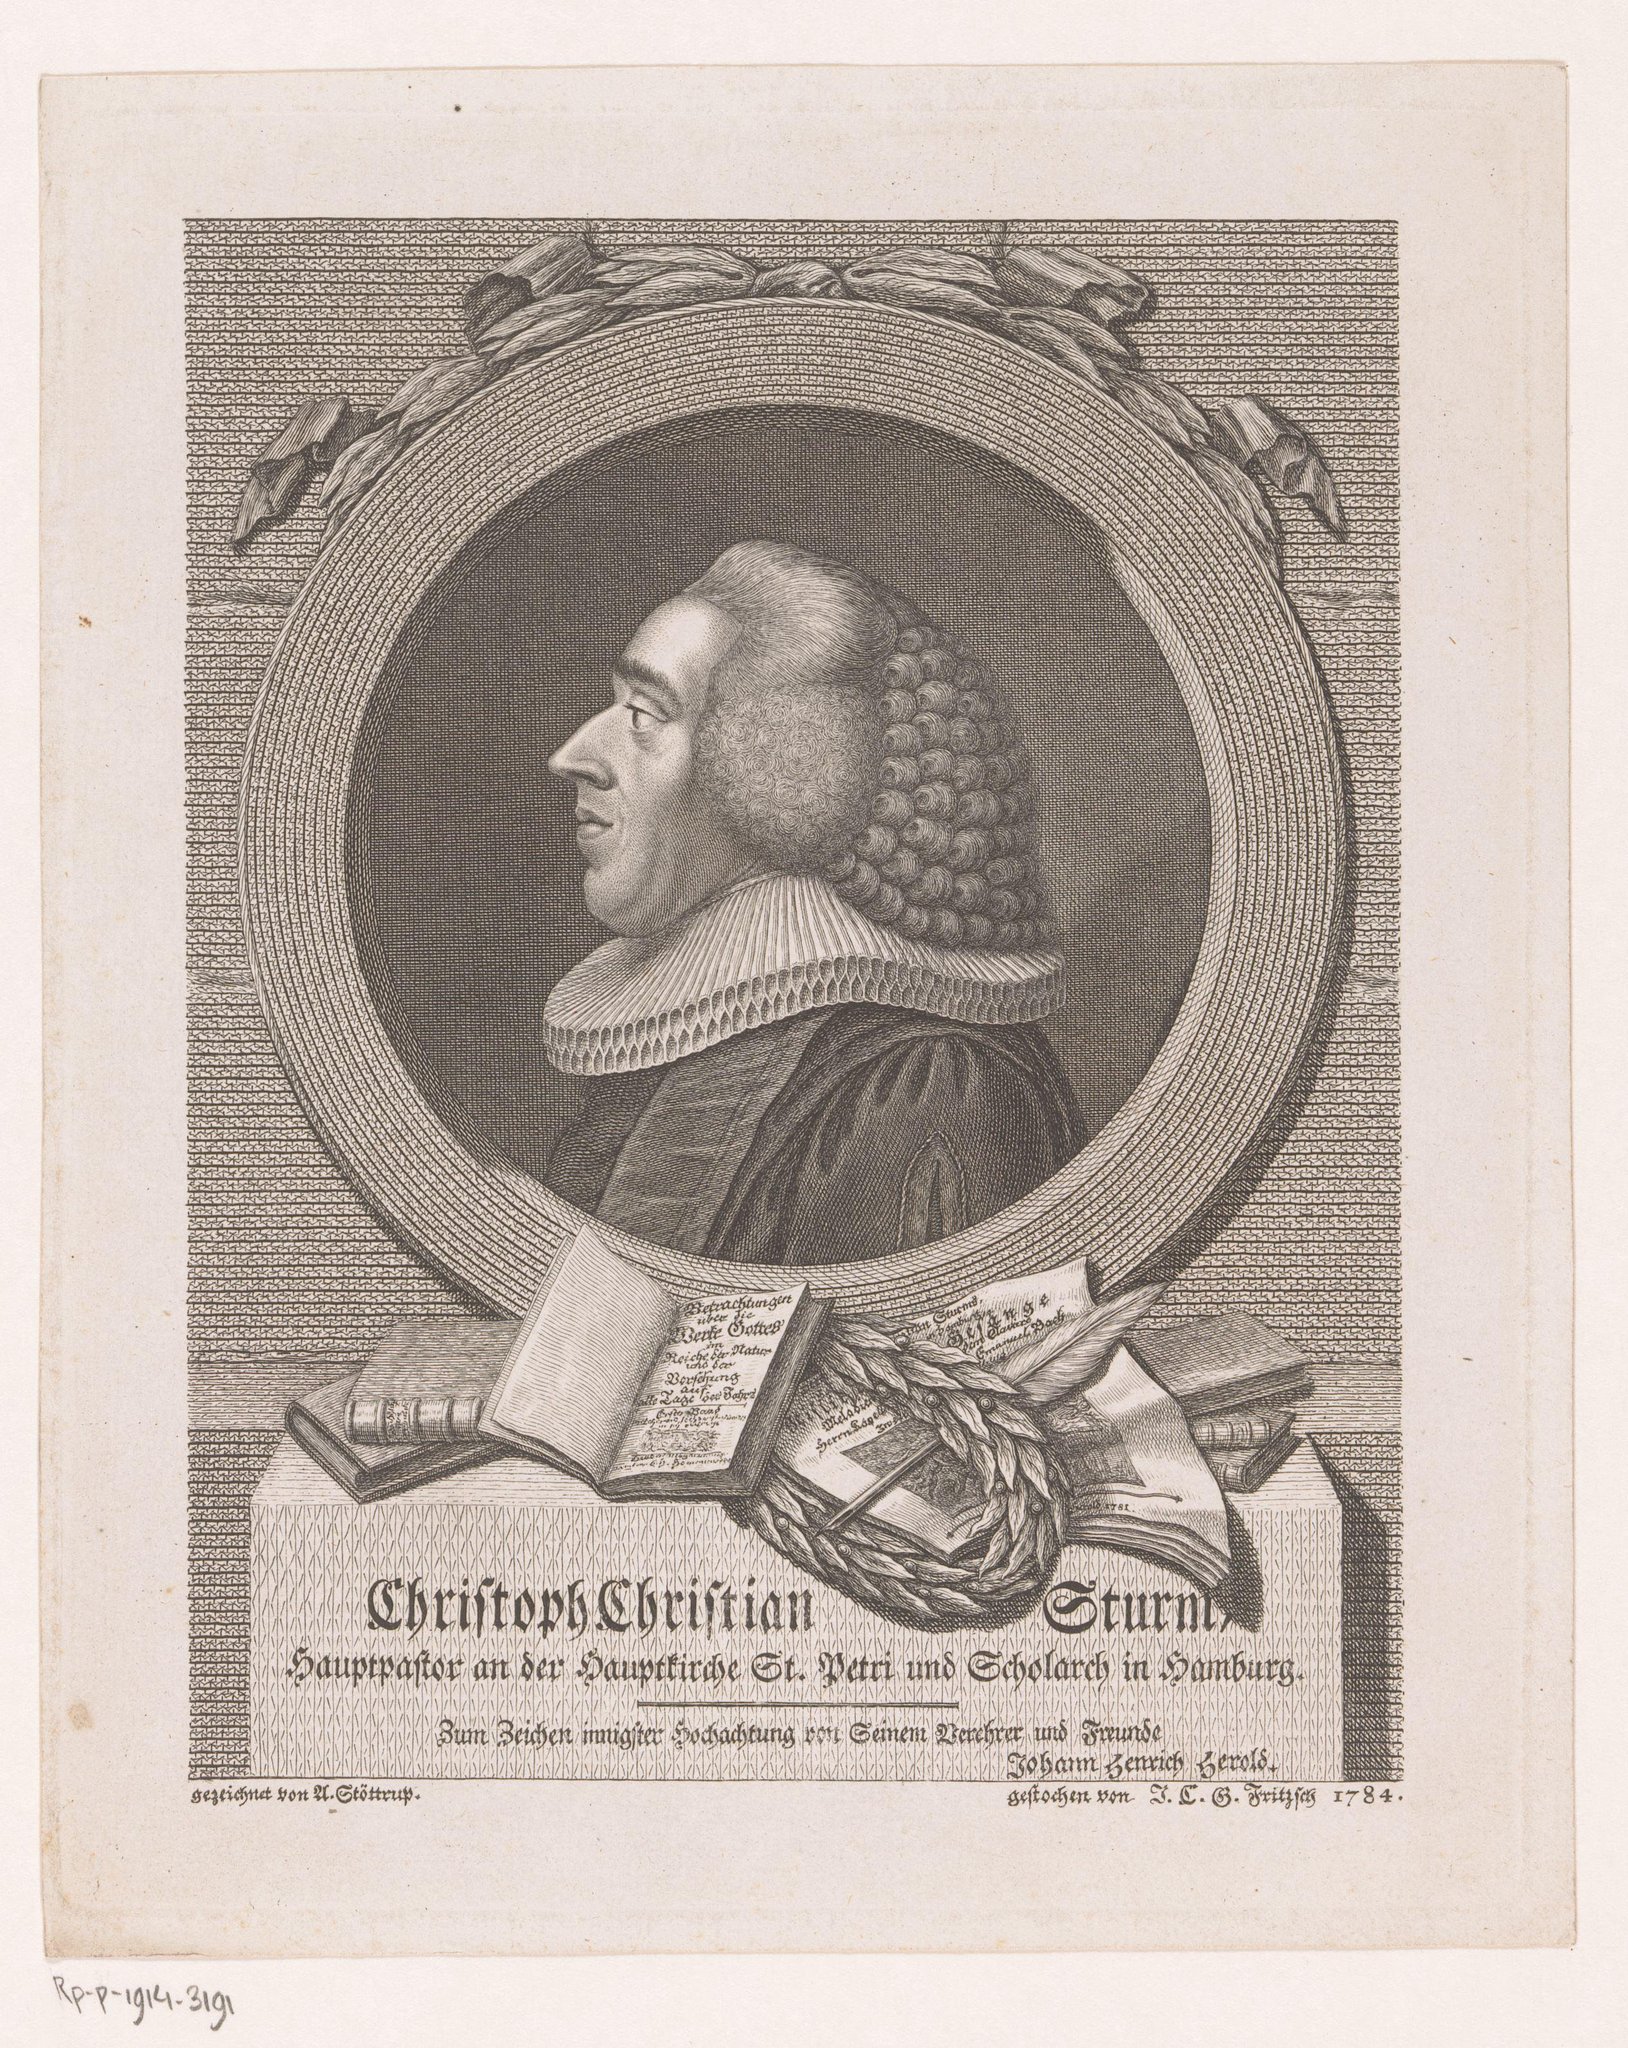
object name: print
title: Portret van Christoph Christian Sturm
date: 1784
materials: paper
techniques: engraving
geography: hamburg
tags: augsburg, honouring the artist with laurel wreath, writing tools, ornament ~ medallion, historical persons, book, ornament ~ festoon, garland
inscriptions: collector's mark: Lugt 2228